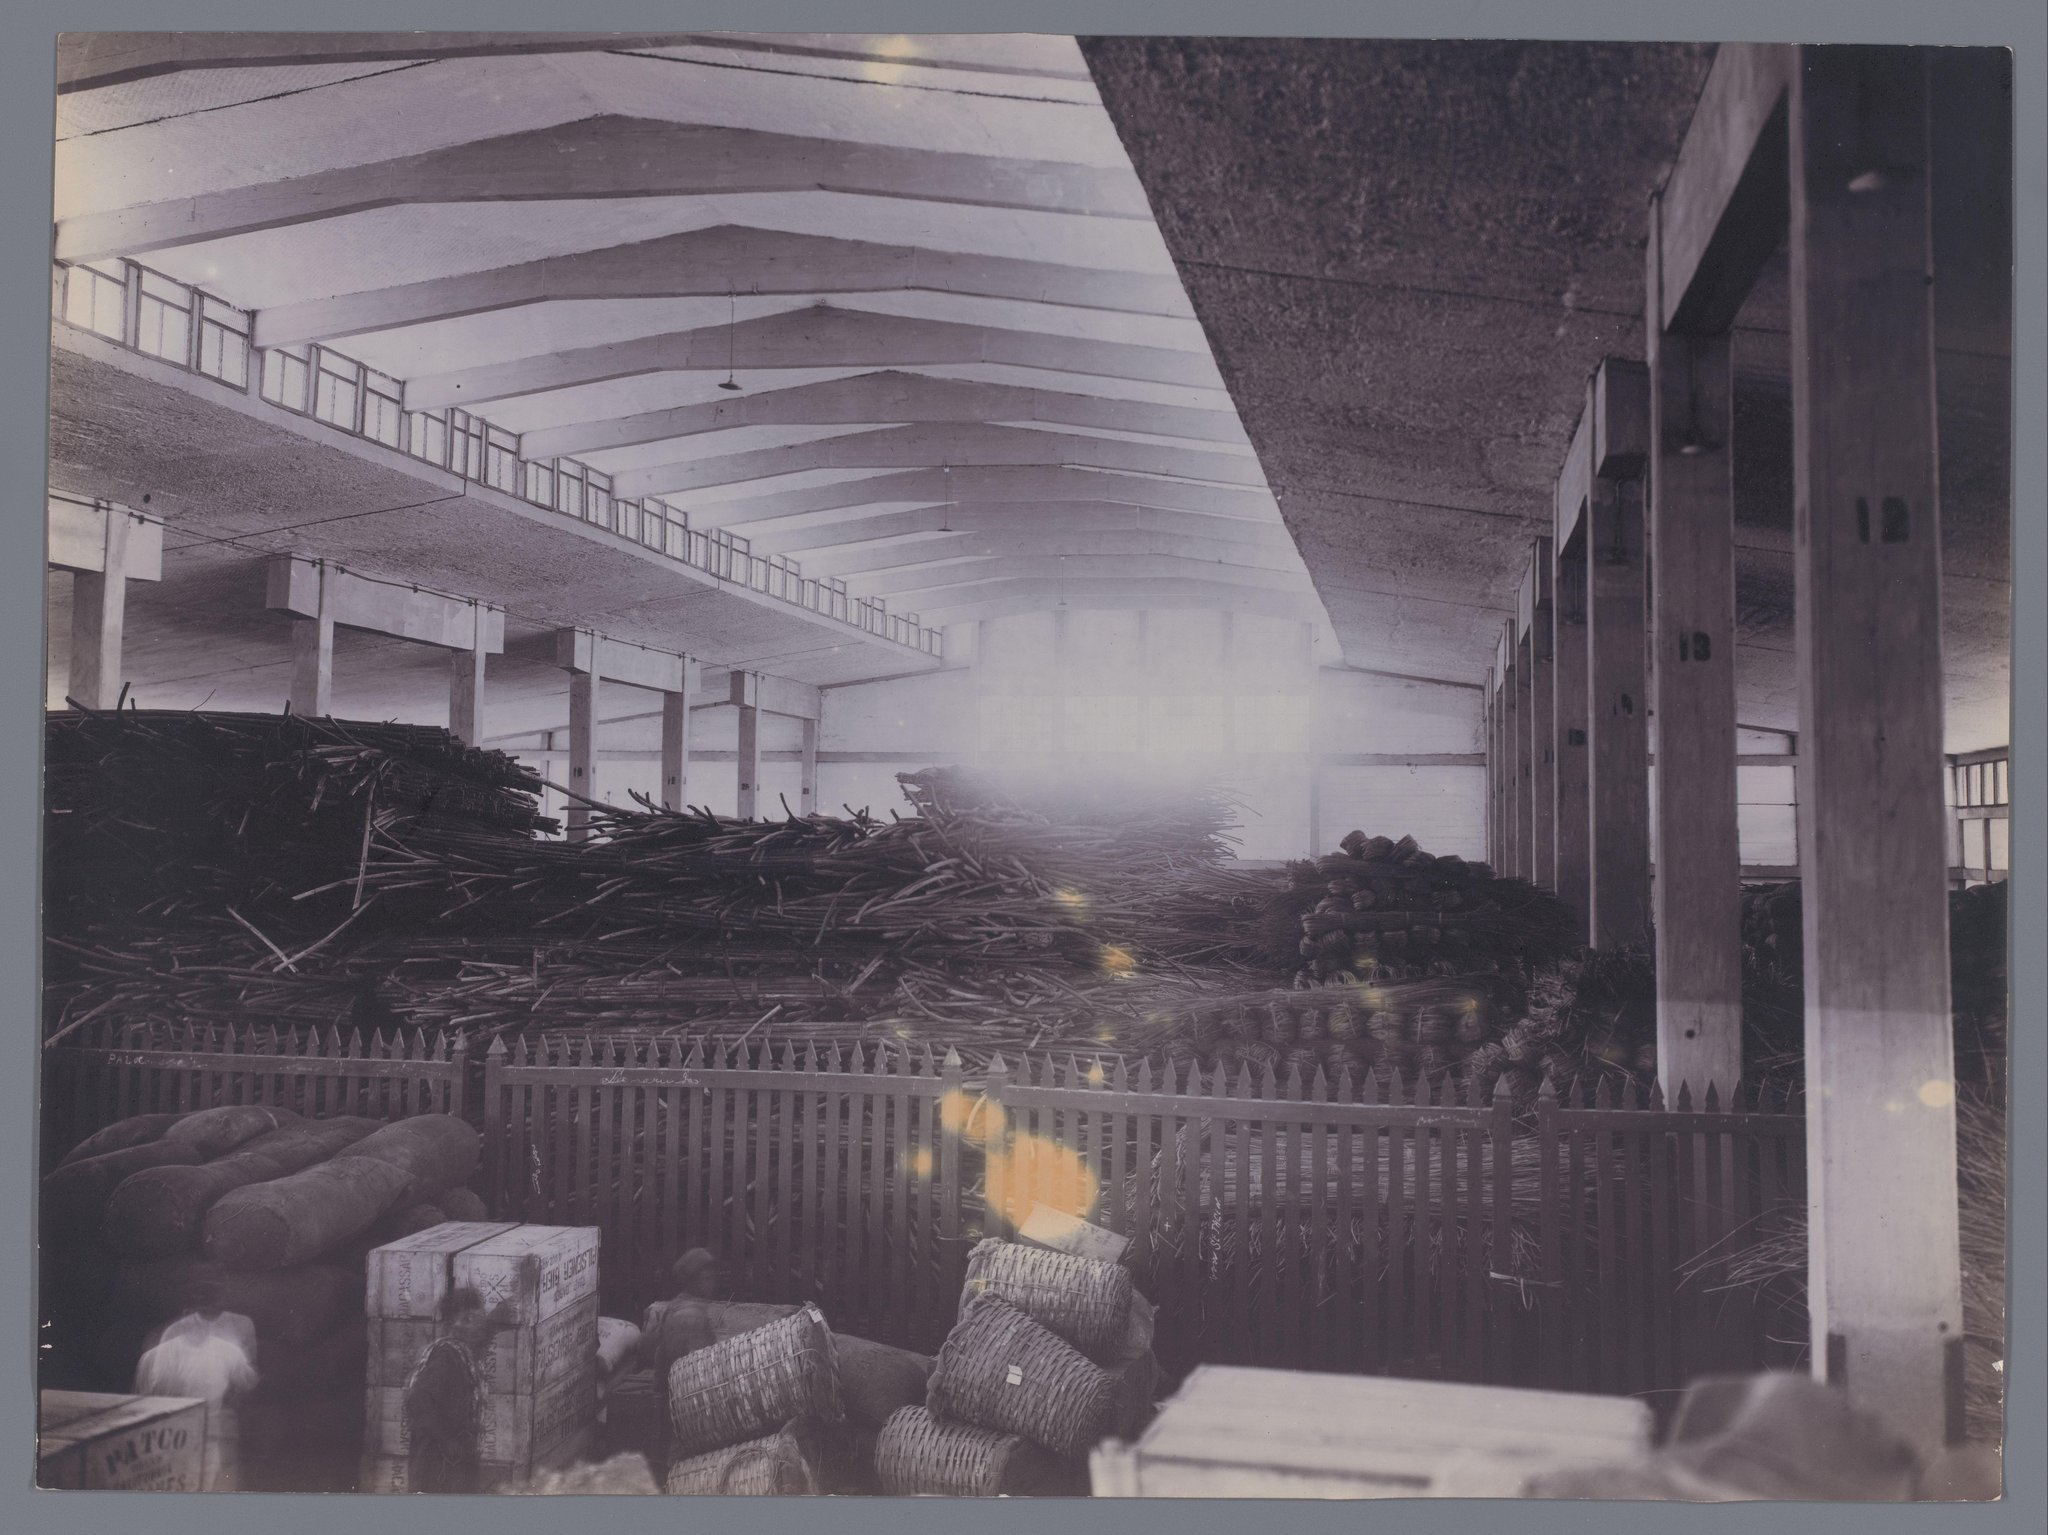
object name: photograph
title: Loods met betonijzer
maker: Anonymous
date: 1921-1922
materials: photographic support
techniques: gelatin silver print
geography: belawan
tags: warehouse (~ harbour), building-site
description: Gezicht in een loods waar betonijzer is opgeslagen. Onderdeel van de groep van losse foto's over de aanleg van de haven Belawan aan de kust voor Medan, Sumatra 1921-1922.